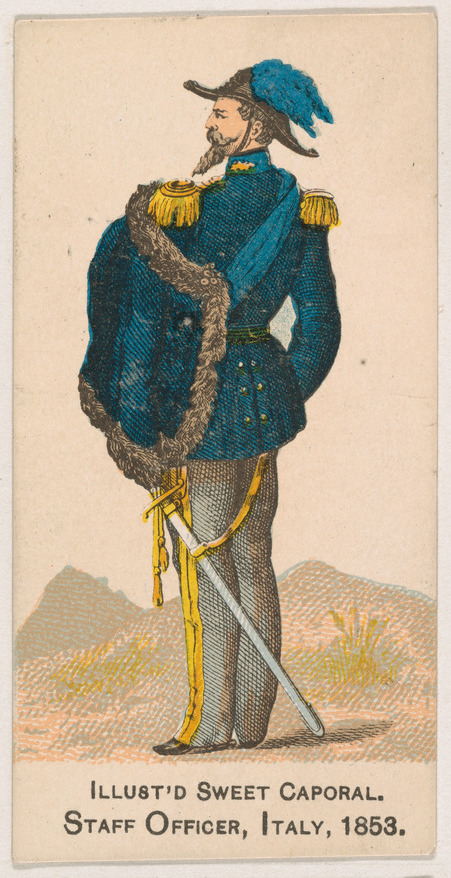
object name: print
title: Staff Officer, Italy, 1853, from the Military Series (N224) issued by Kinney Tobacco Company to promote Sweet Caporal Cigarettes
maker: kinney brothers tobacco company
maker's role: publisher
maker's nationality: american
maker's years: 1869-2011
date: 1888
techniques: color lithograph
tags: military,swords,men,profiles